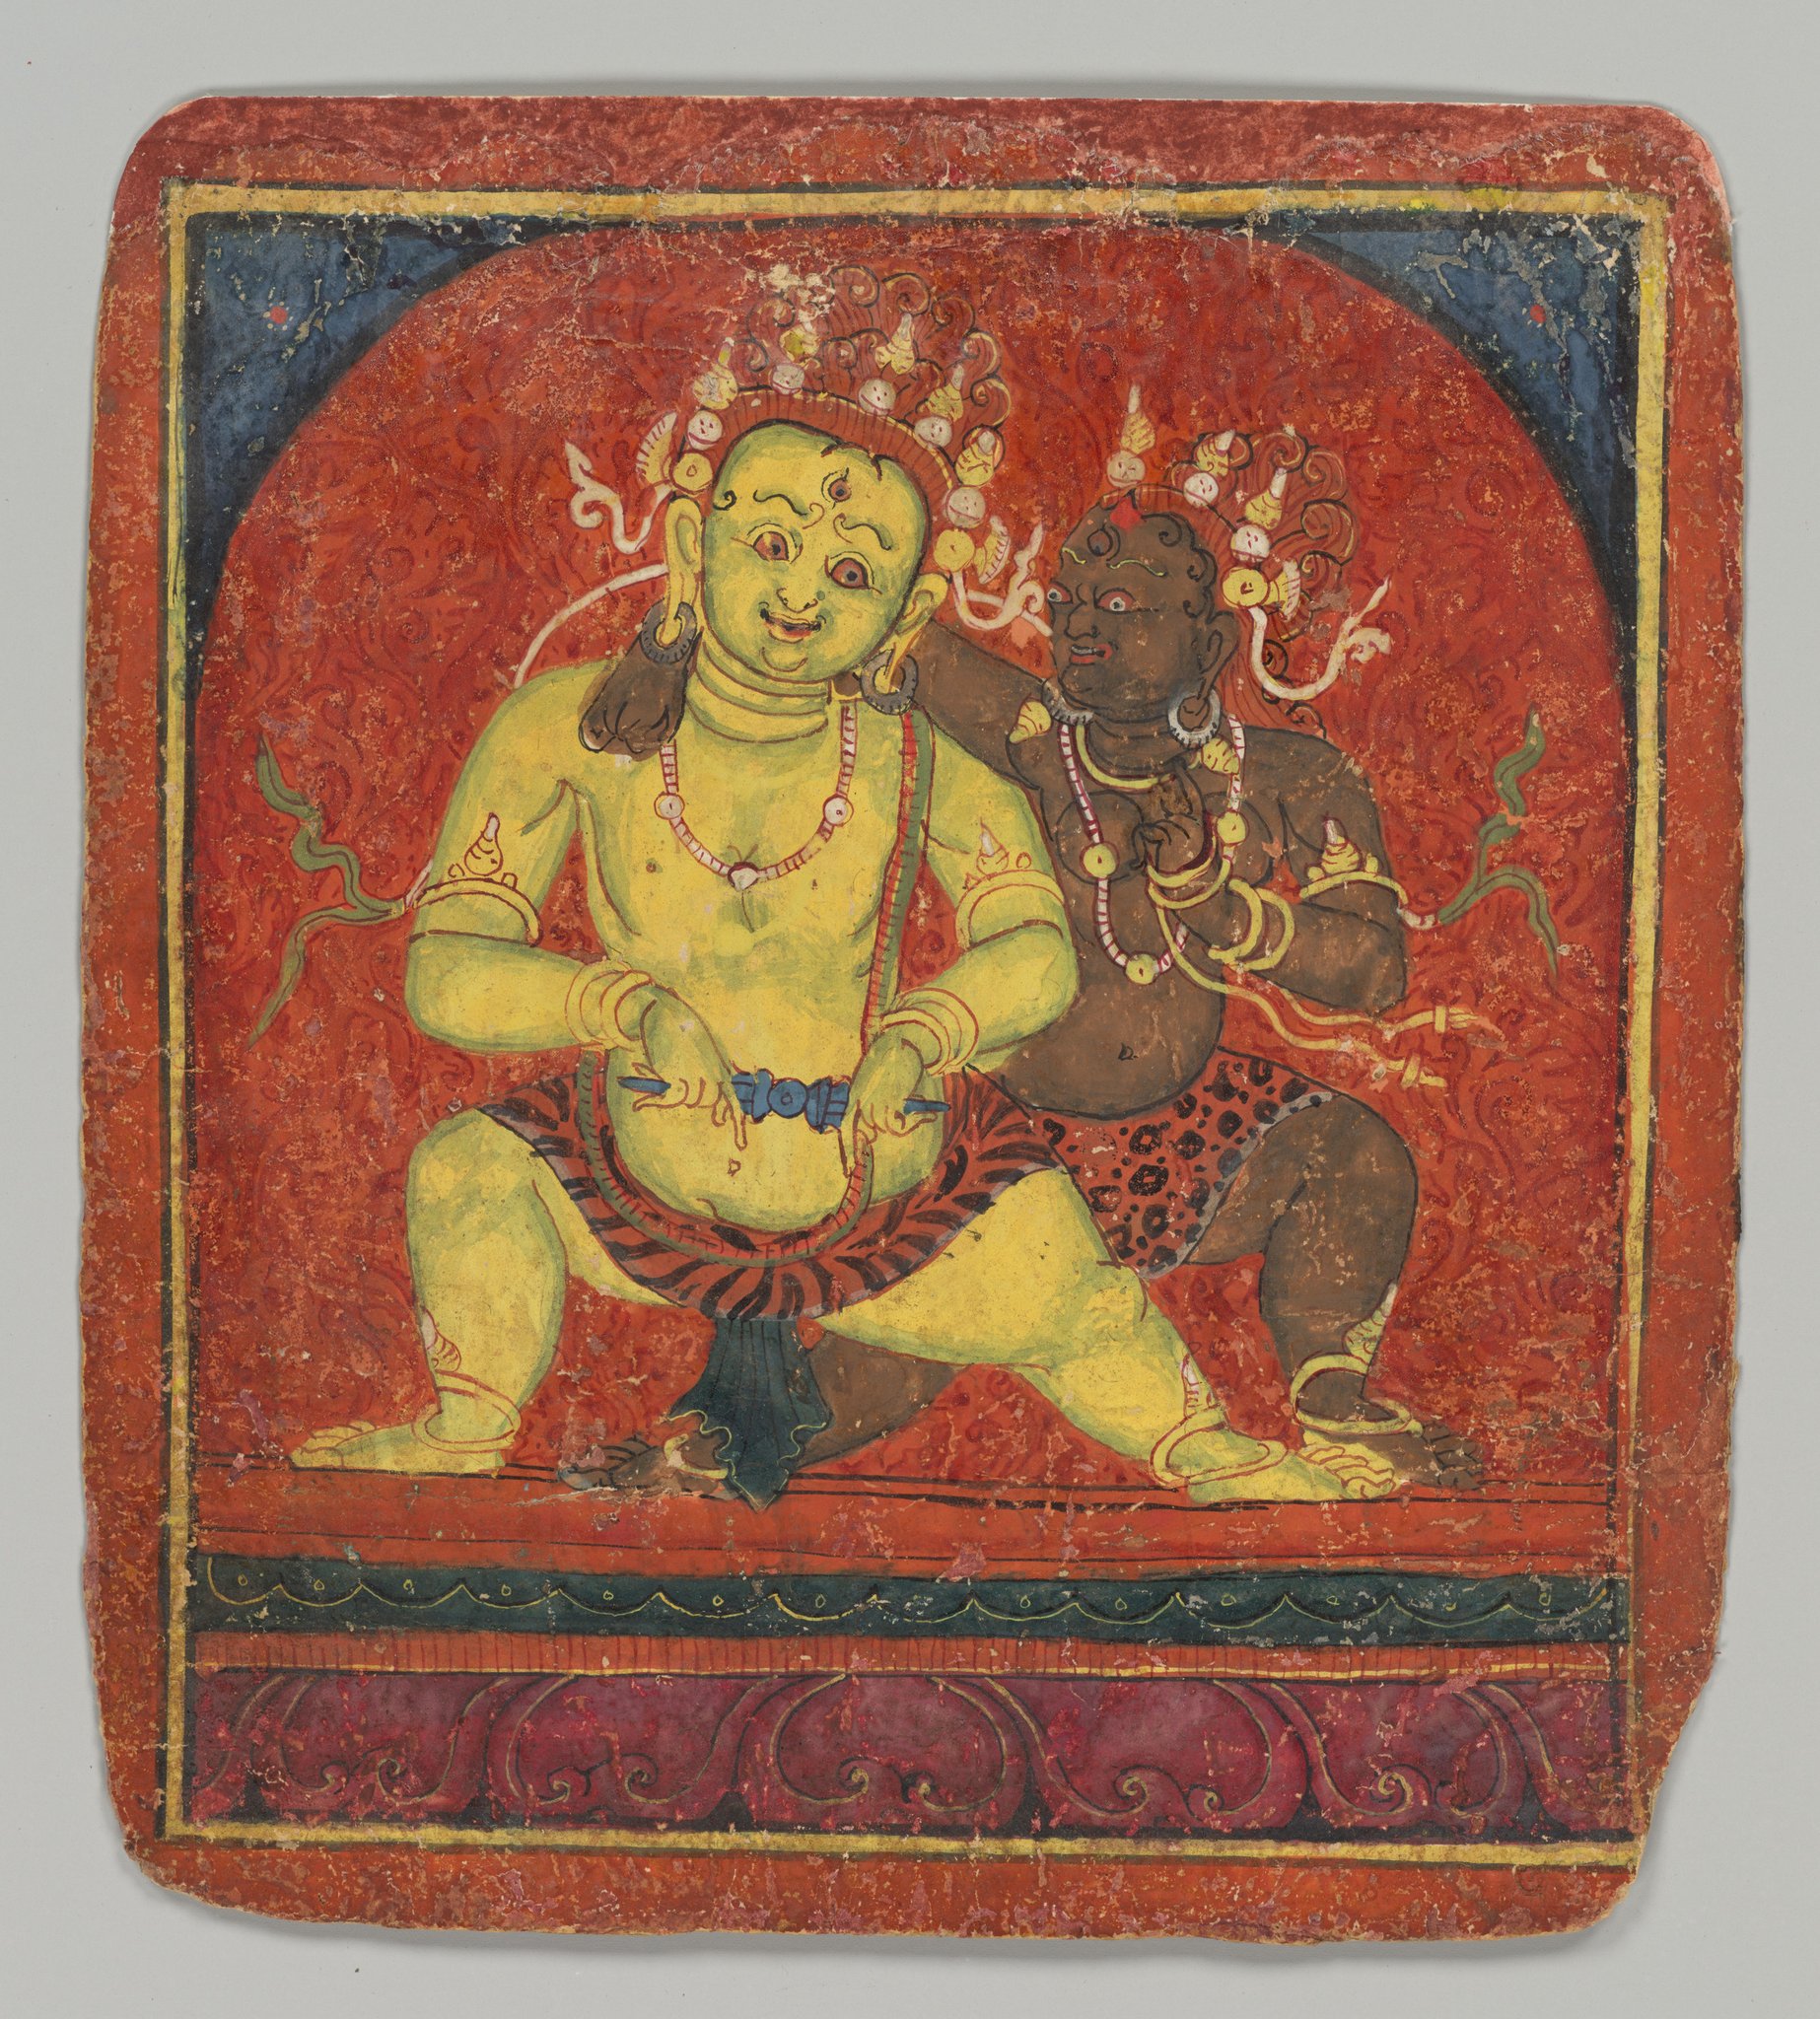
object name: initiation card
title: Initiation Card (Tsakalis): Mahakala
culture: tibetan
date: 1401-1433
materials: paper, watercolor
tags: deities